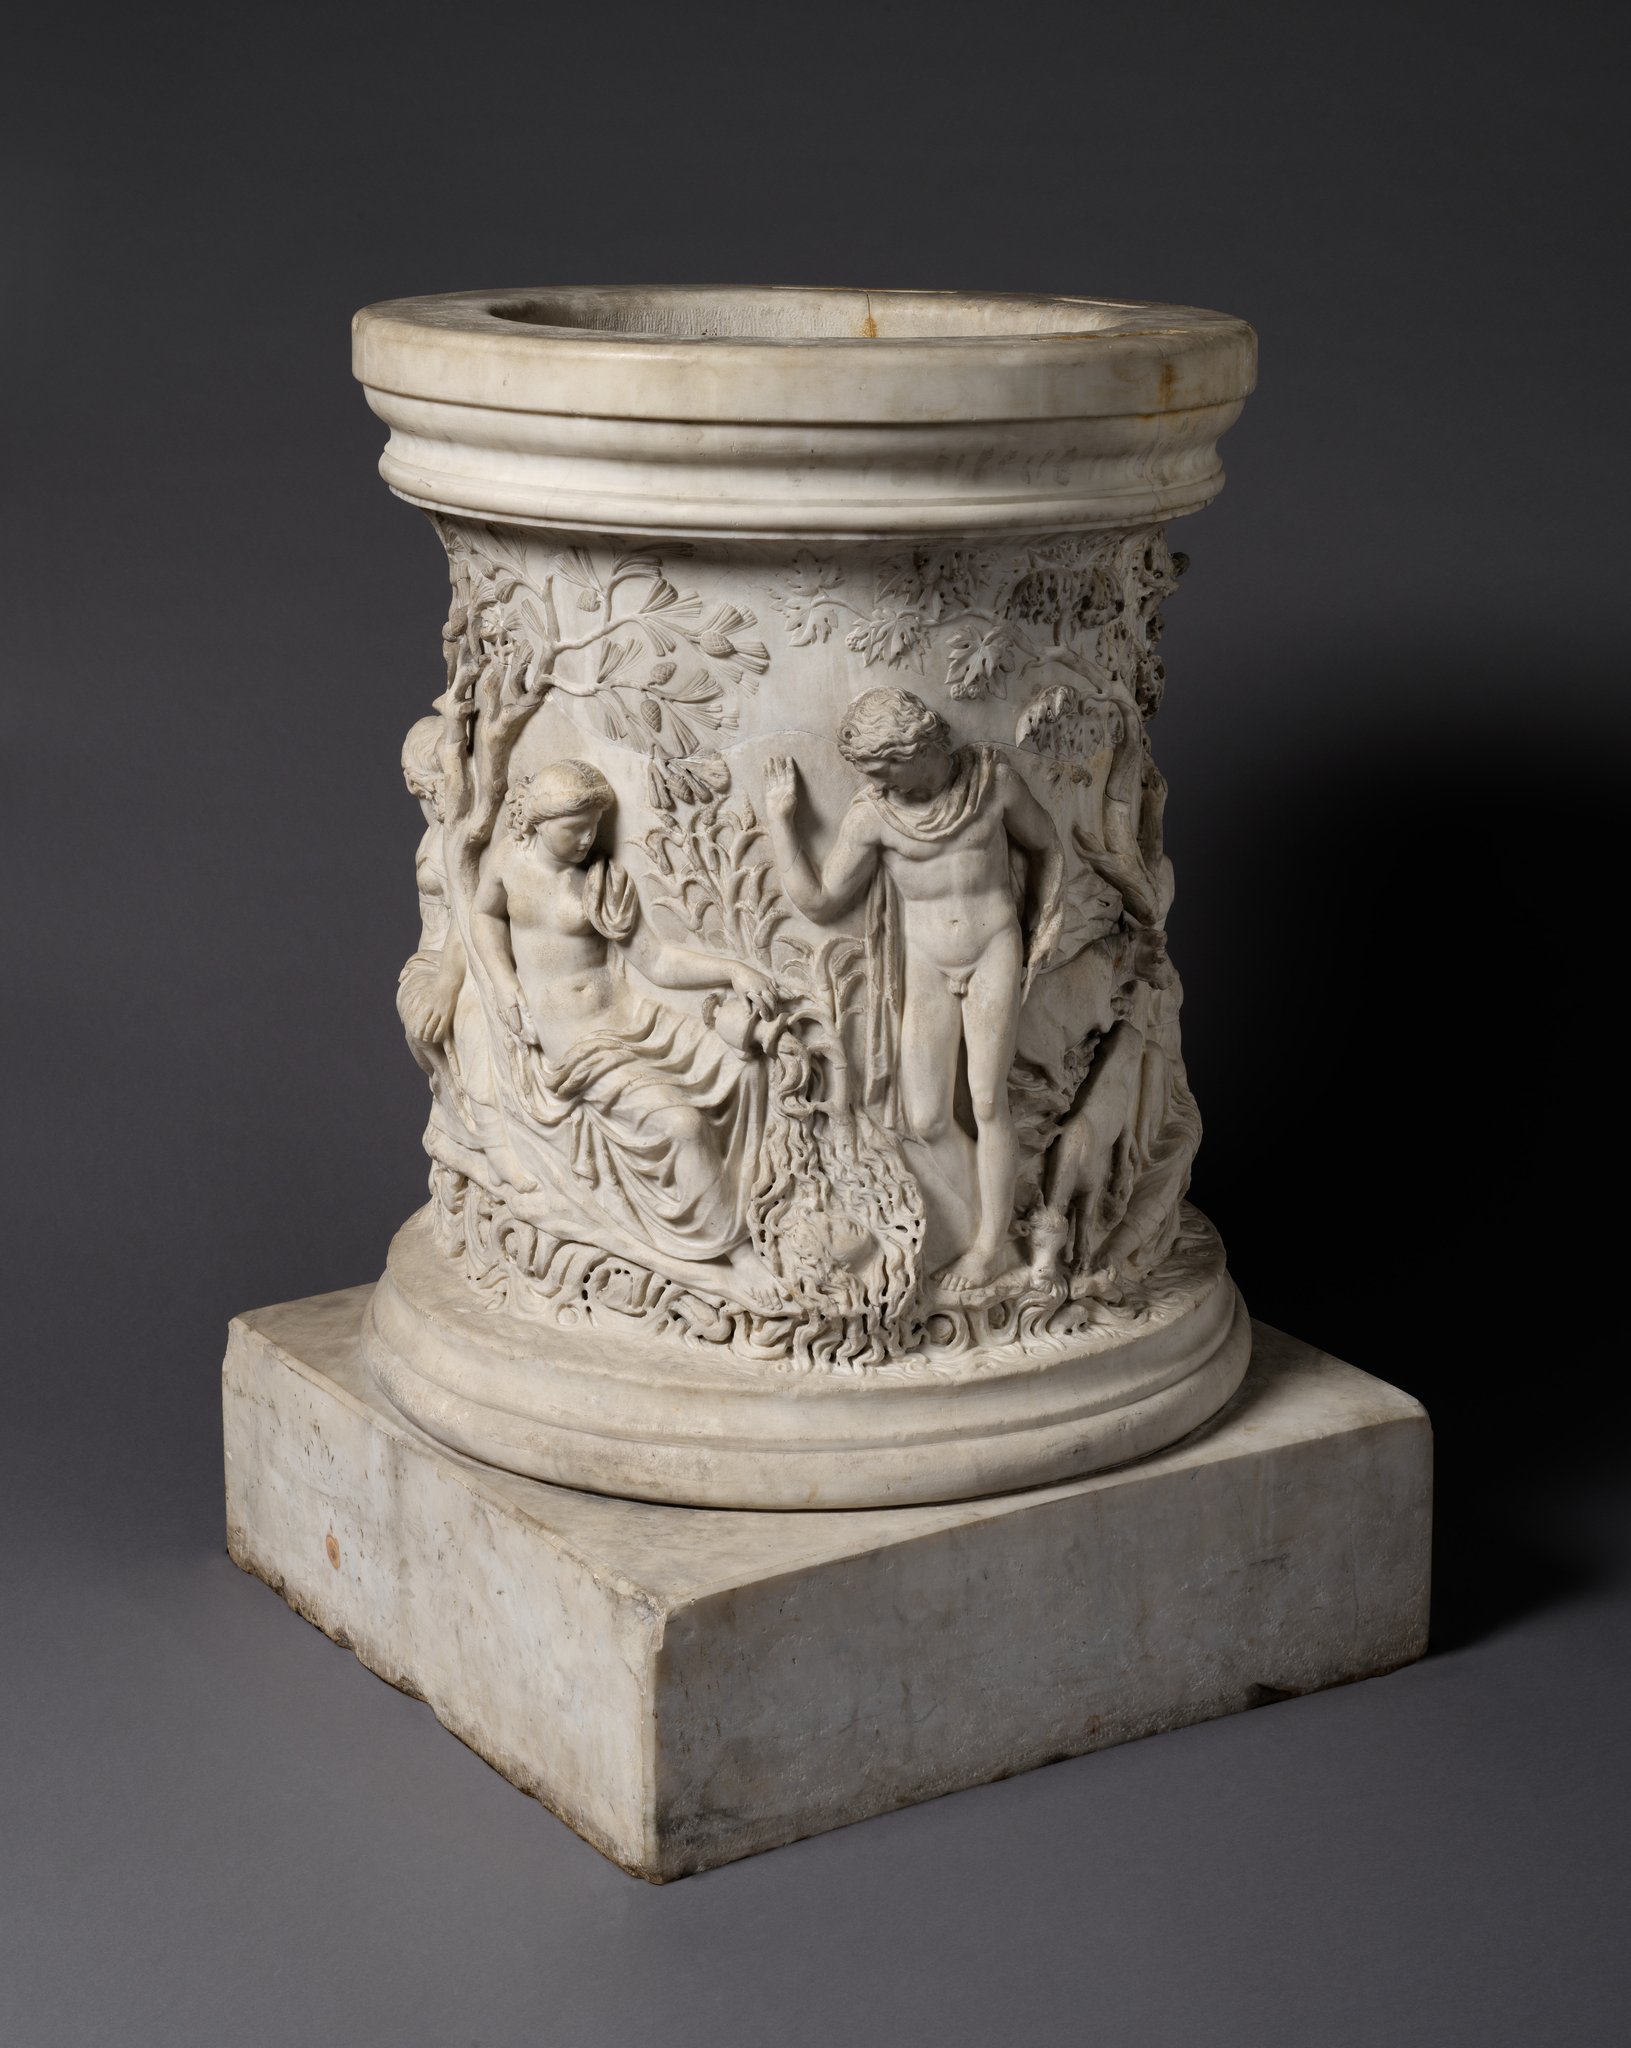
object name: puteal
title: Puteal (wellhead) with Narcissus and Echo, and Hylas and the Nymphs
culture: roman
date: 101-200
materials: marble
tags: narcissus,nymphs